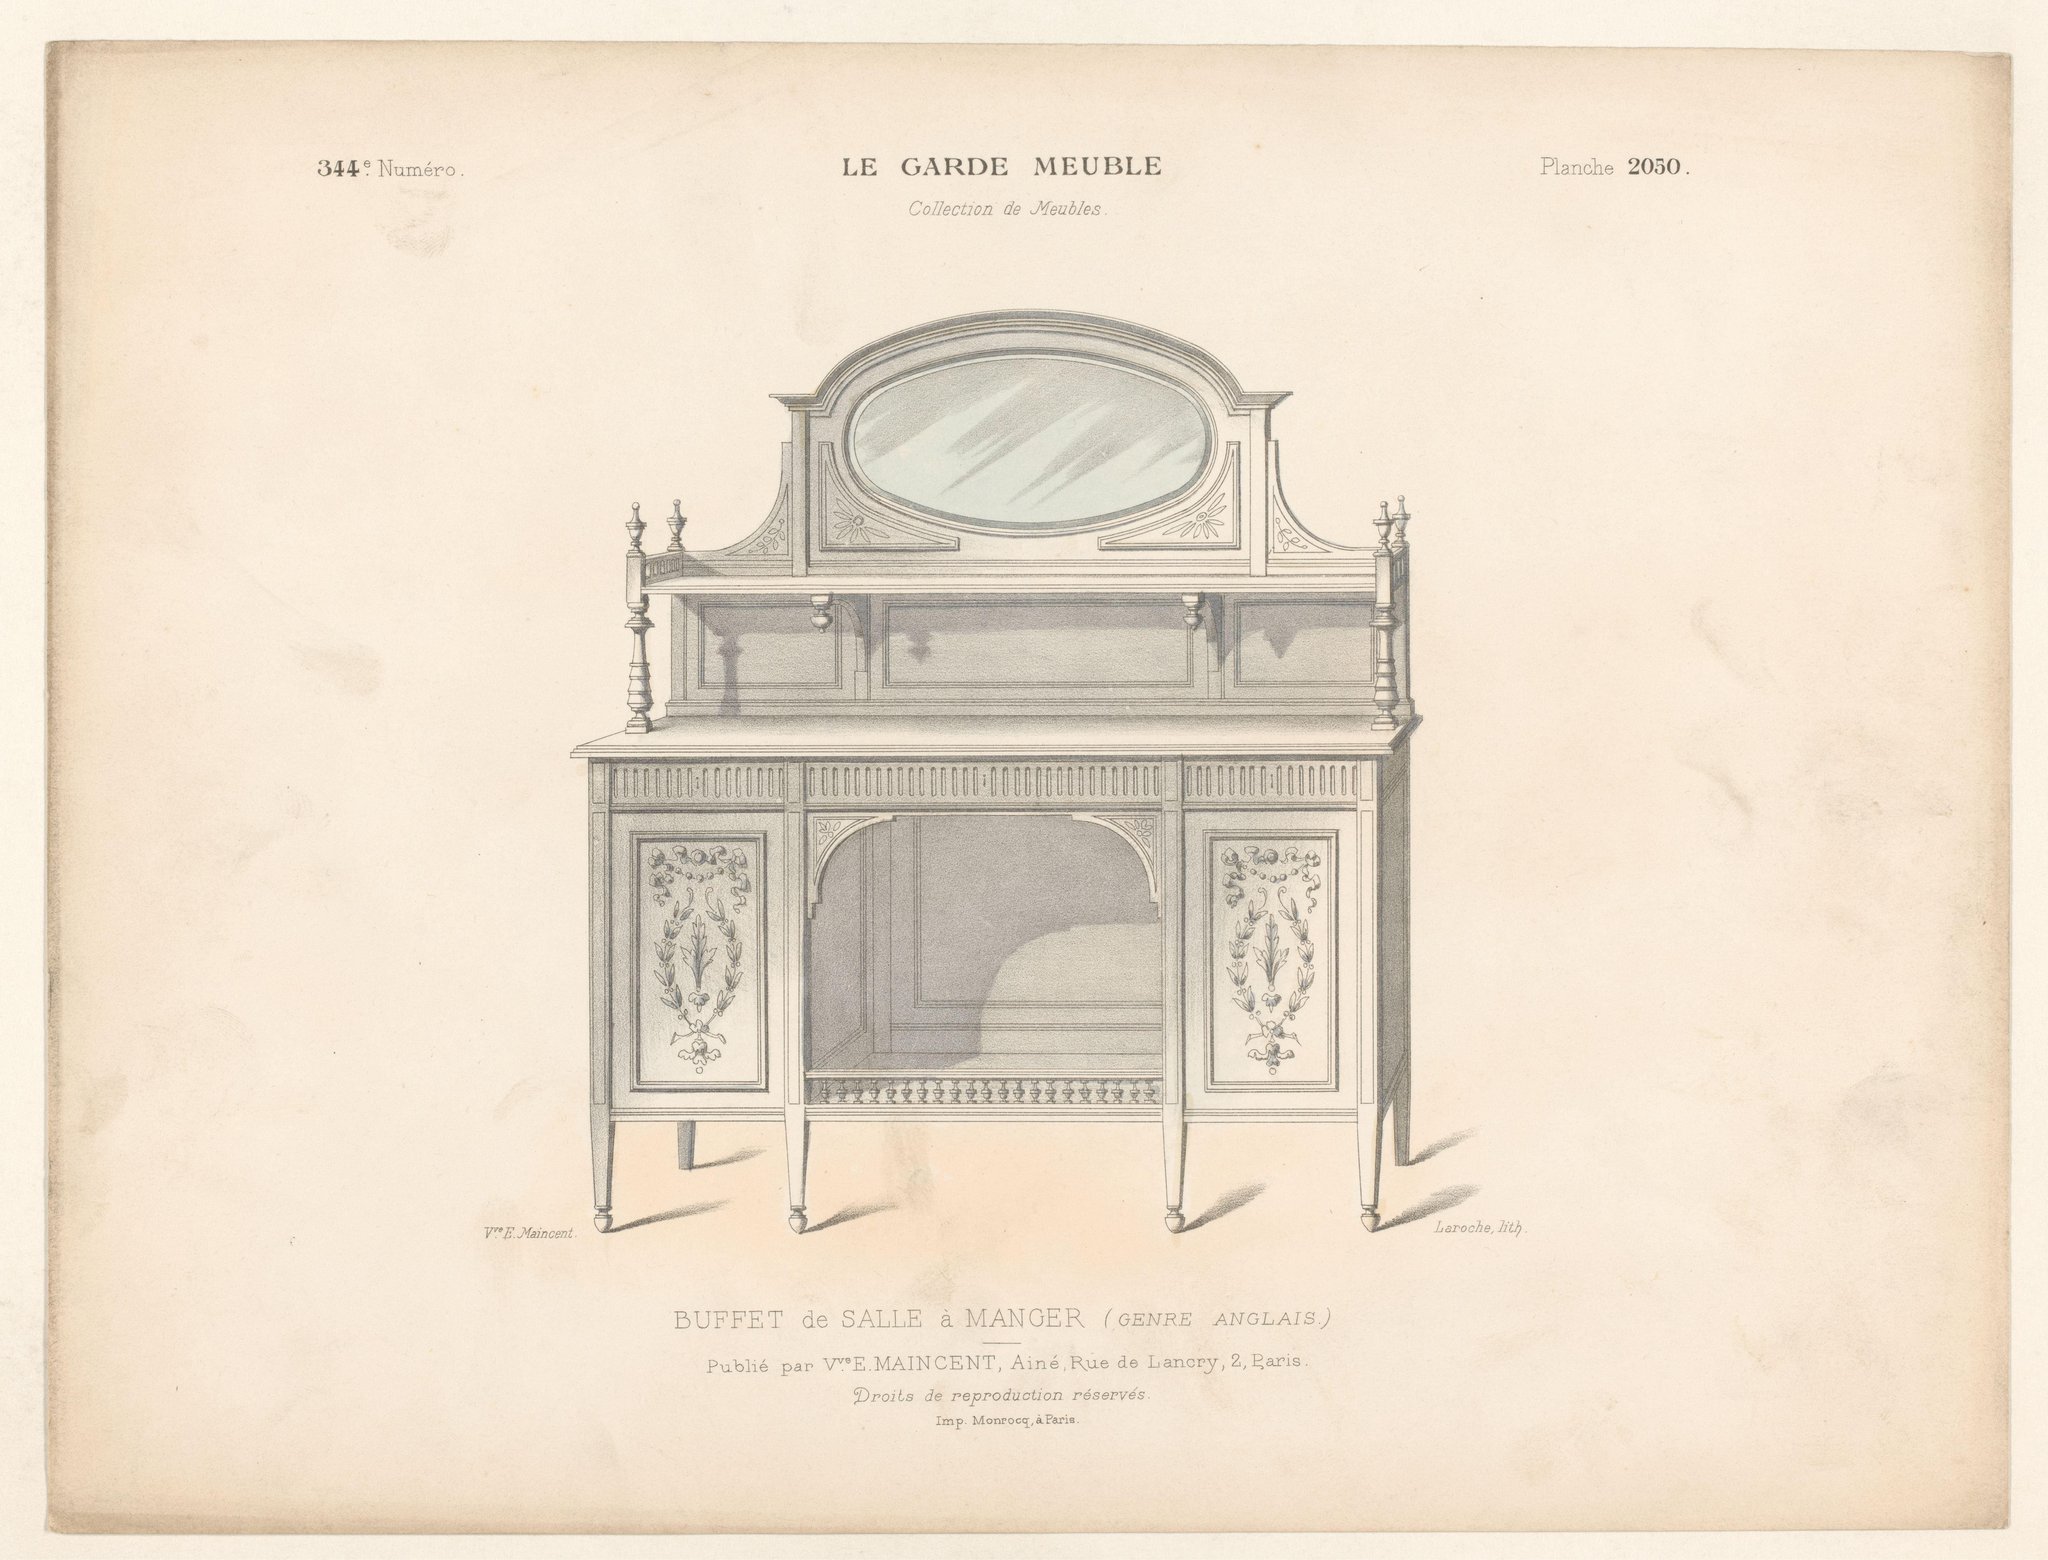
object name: print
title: Buffet de salle à manger (genre Anglais)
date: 1895-1935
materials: paper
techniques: hand coloring, lithograph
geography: paris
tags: furniture for storage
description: Ieder Livraison in de serie Le Garde-Meuble bevat negen platen: drie 'sièges' (zitmeubels), drie 'meubles' (diverse meubels zoals tafels en kasten) en drie 'tentures' (gordijnen en draperieën).